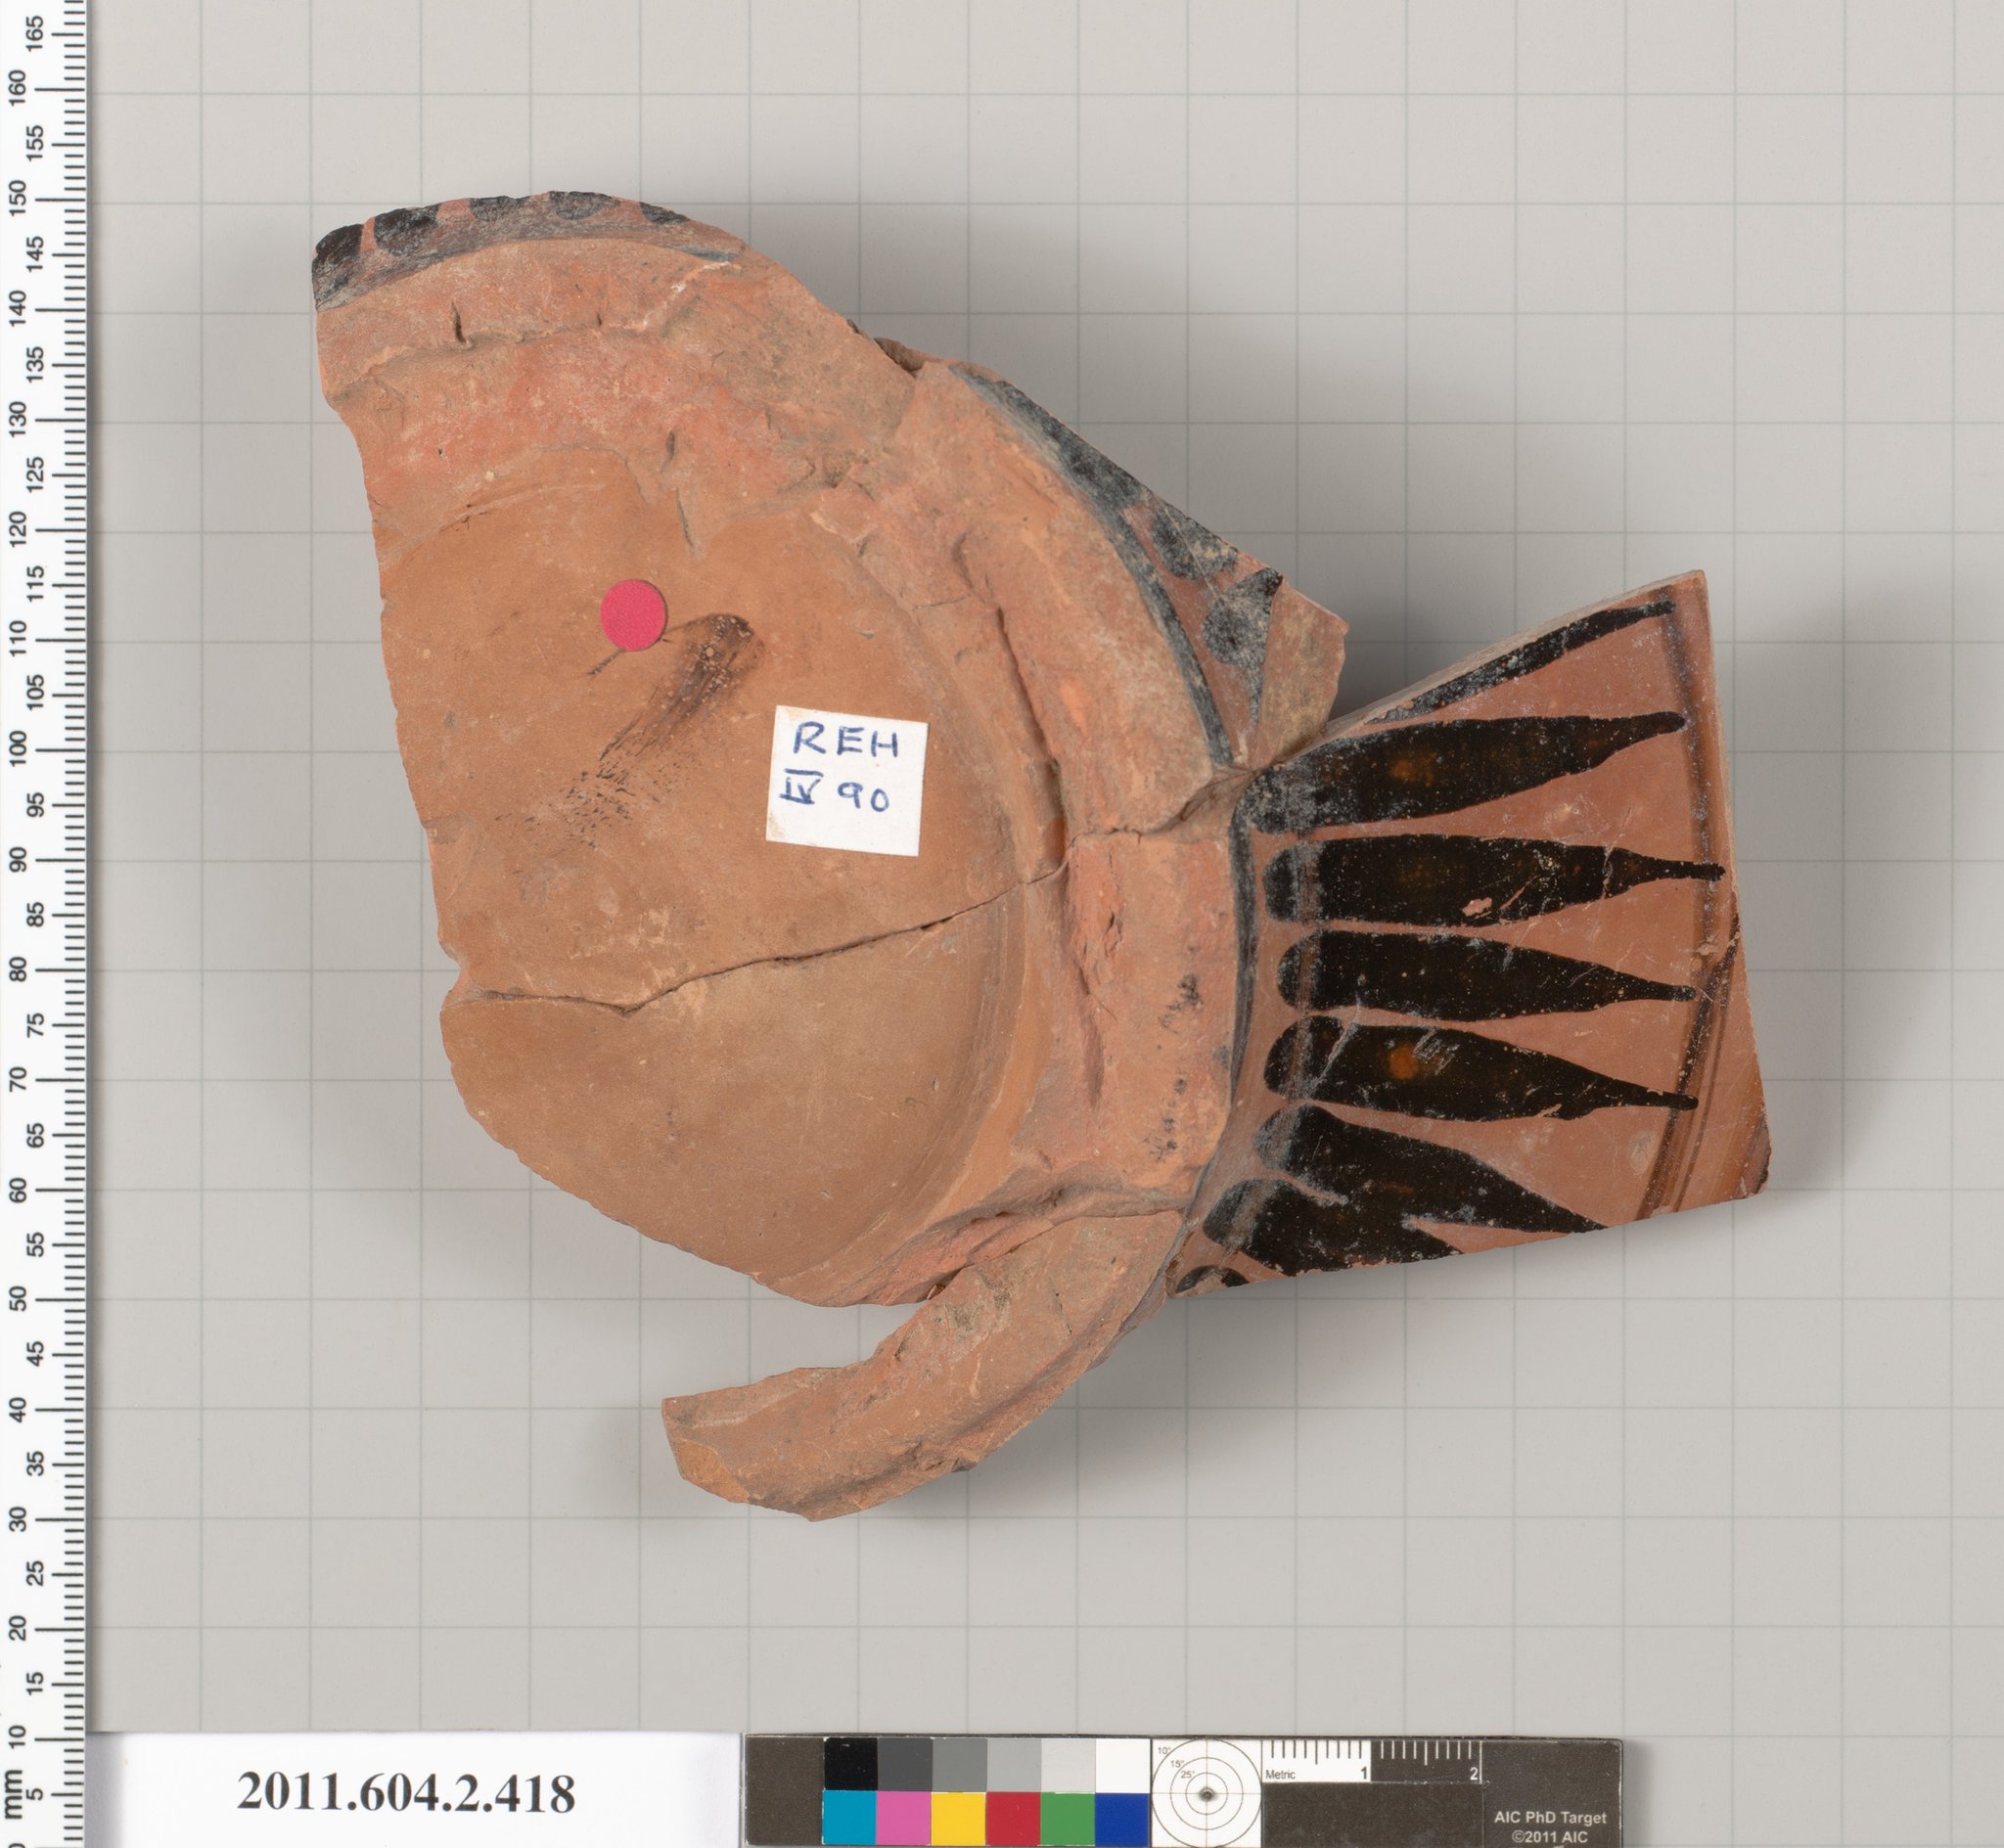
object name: column krater fragment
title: Terracotta fragment of a column-krater (bowl for mixing wine and water)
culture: greek, attic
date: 475-451 BCE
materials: terracotta